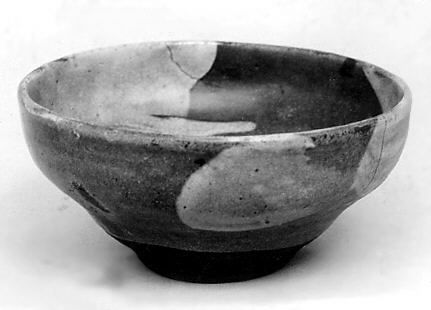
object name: teabowl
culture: japanese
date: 1801-1900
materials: clay, glaze